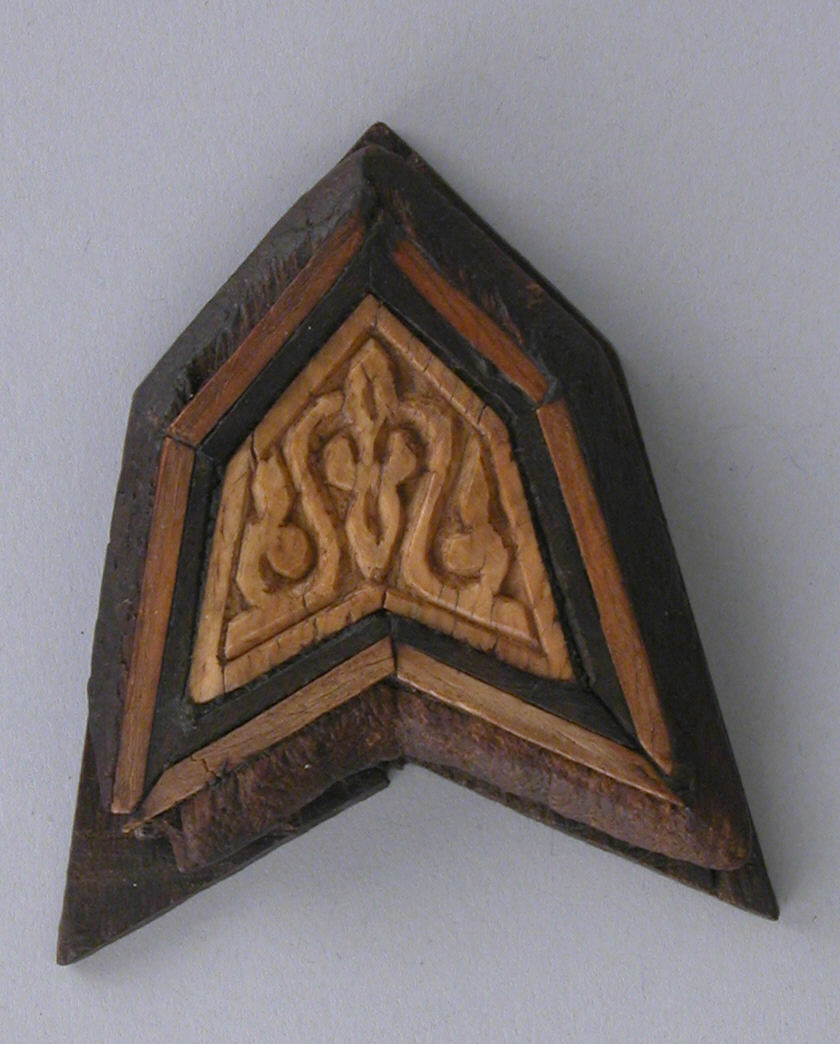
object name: panel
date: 1301-1500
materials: ivory, wood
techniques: carving, inlay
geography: egypt